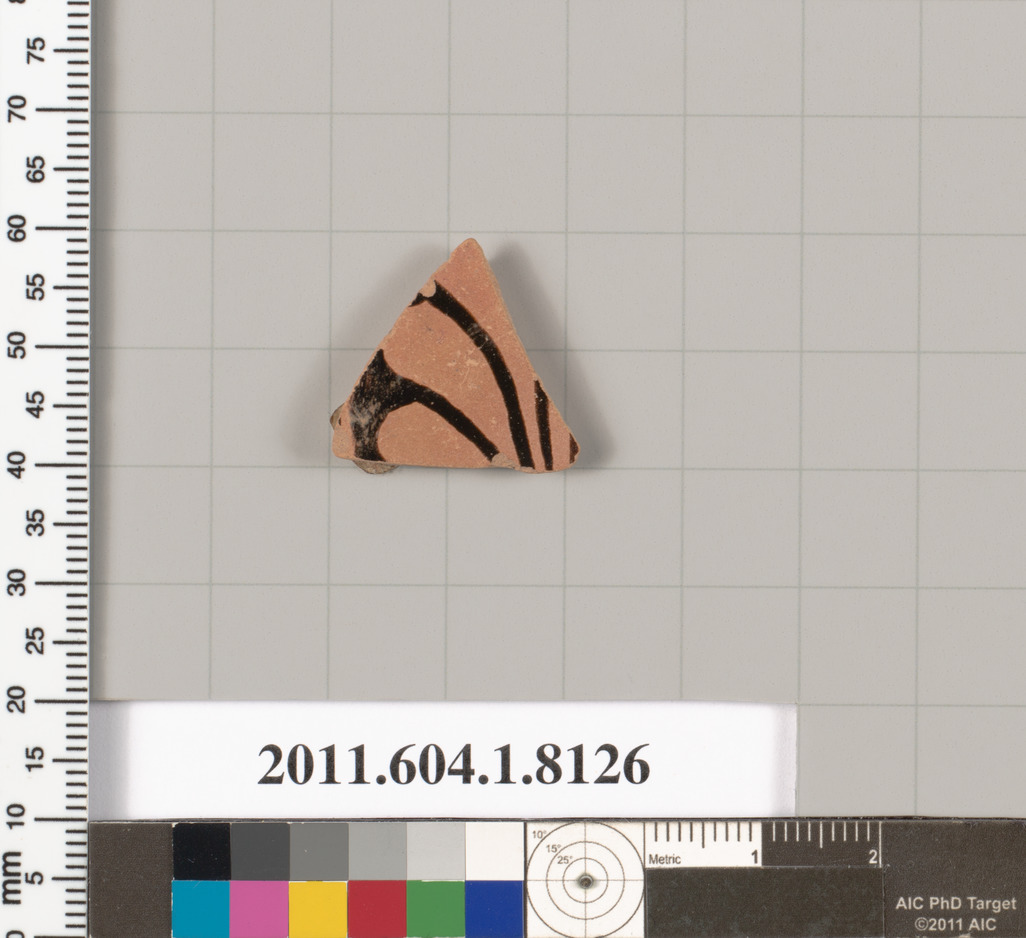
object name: kylix fragment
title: Terracotta fragment of a kylix (drinking cup)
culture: greek, attic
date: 534-468 BCE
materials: terracotta